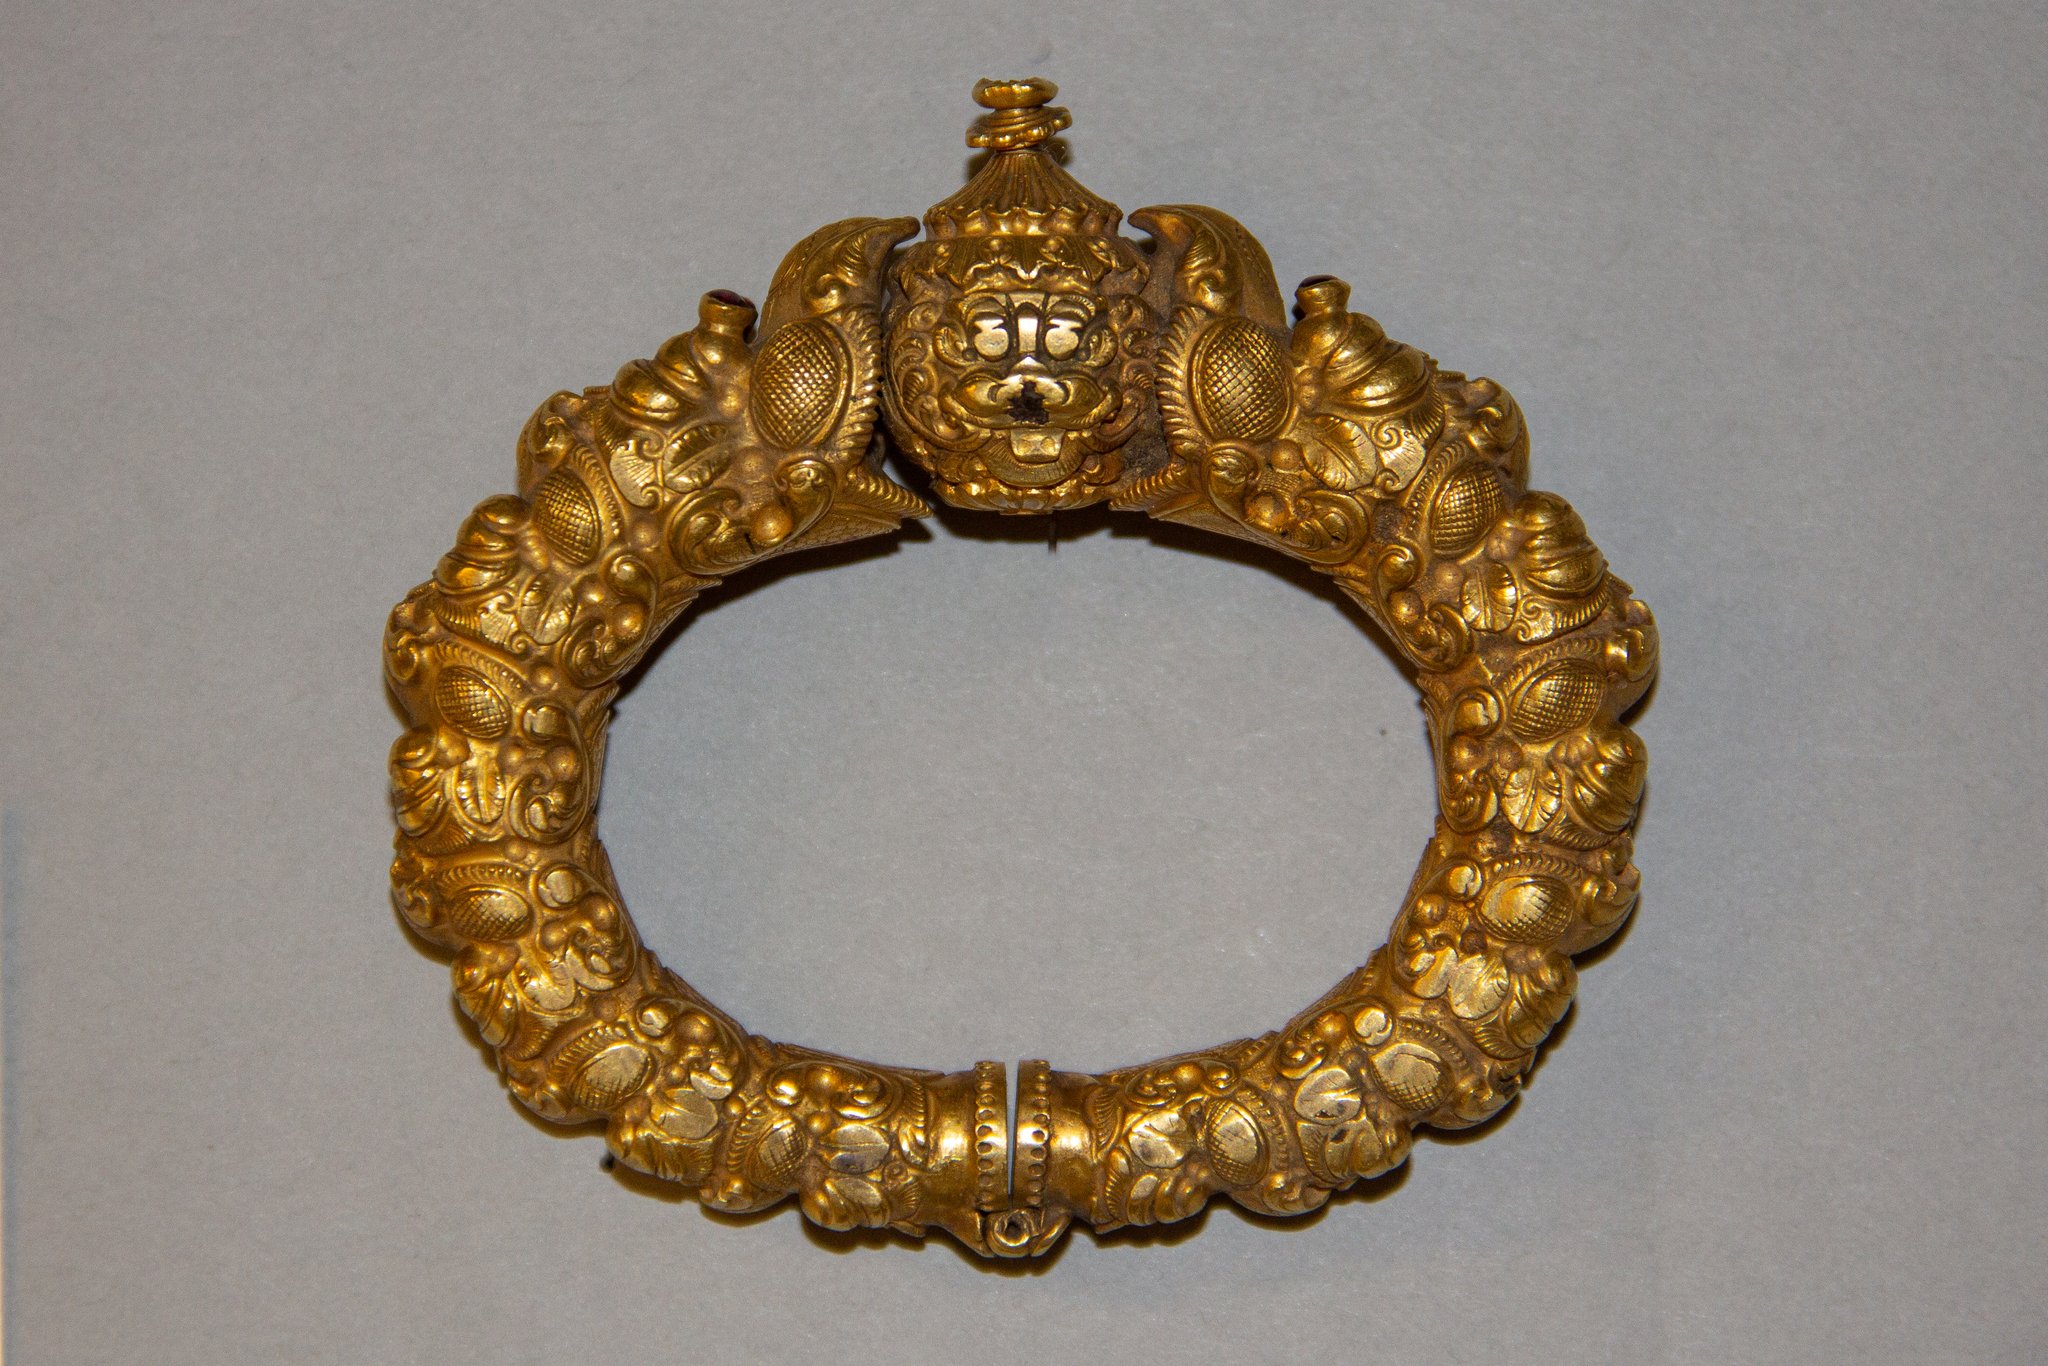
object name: bracelet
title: Bracelet (Kada), One of a Pair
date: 1801-1900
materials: gold, gemstone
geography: india